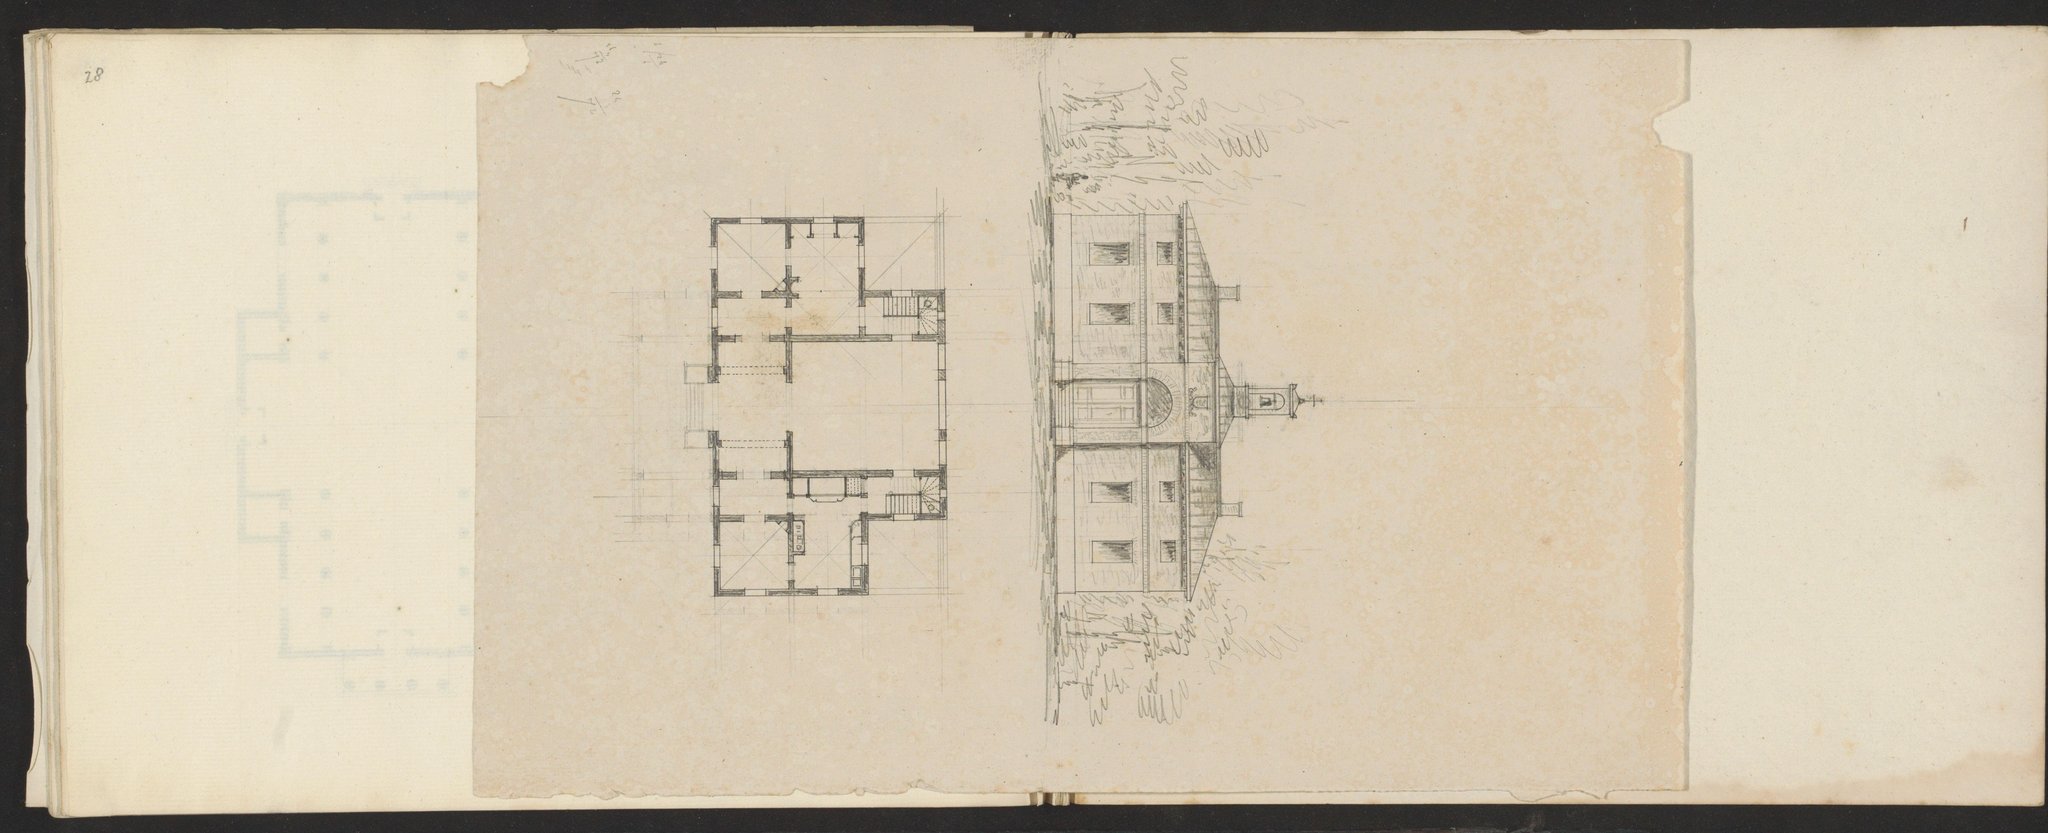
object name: sketchbook leaf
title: Plattegrond en opstand van de gevel van een villa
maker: willem springer jr.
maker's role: draughtsman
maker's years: 1815-1907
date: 1825-1907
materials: ink, paper, pencil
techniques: pen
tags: villa, façade (of house or building), plan ~ architecture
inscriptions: annotation: ‘...’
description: Verso van een los blad tussen pagina 28 en de binnenzijde van de omslag van een schetsboek met 28 pagina's.